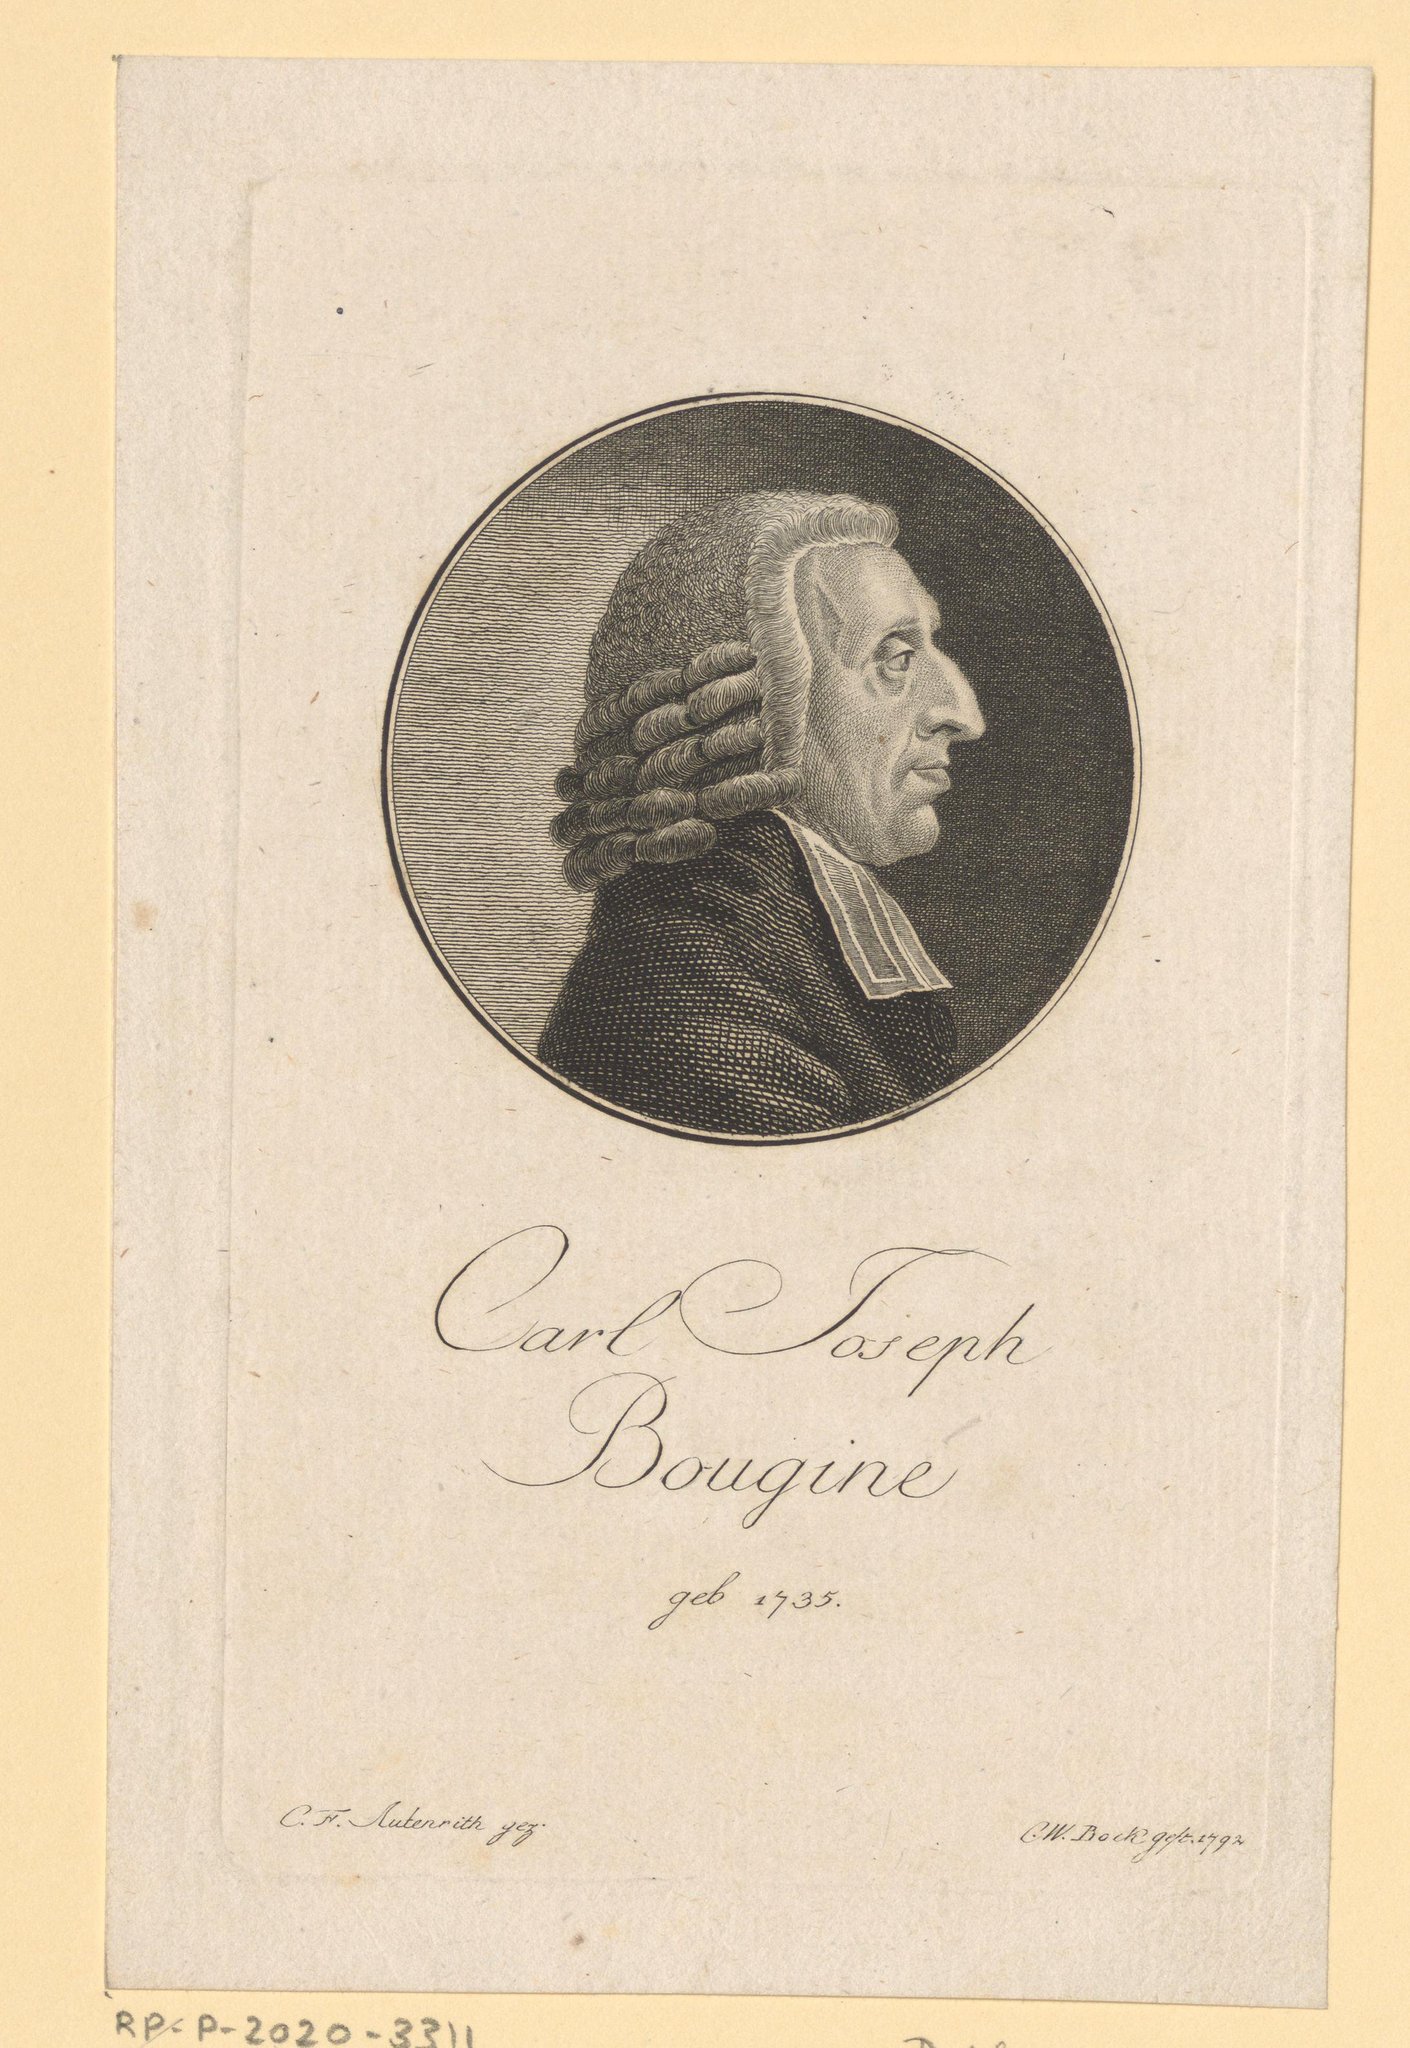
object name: print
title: Portret van Karl Joseph Bouginé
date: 1792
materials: paper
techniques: engraving, etching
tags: historical persons, portrait of a writer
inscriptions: date